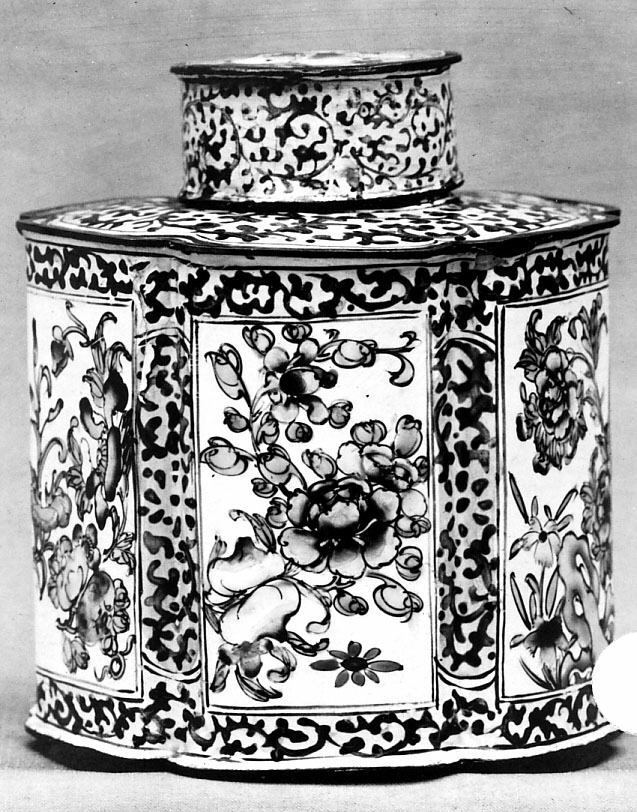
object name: tea caddy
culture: chinese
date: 1801-1900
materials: enamel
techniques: painting